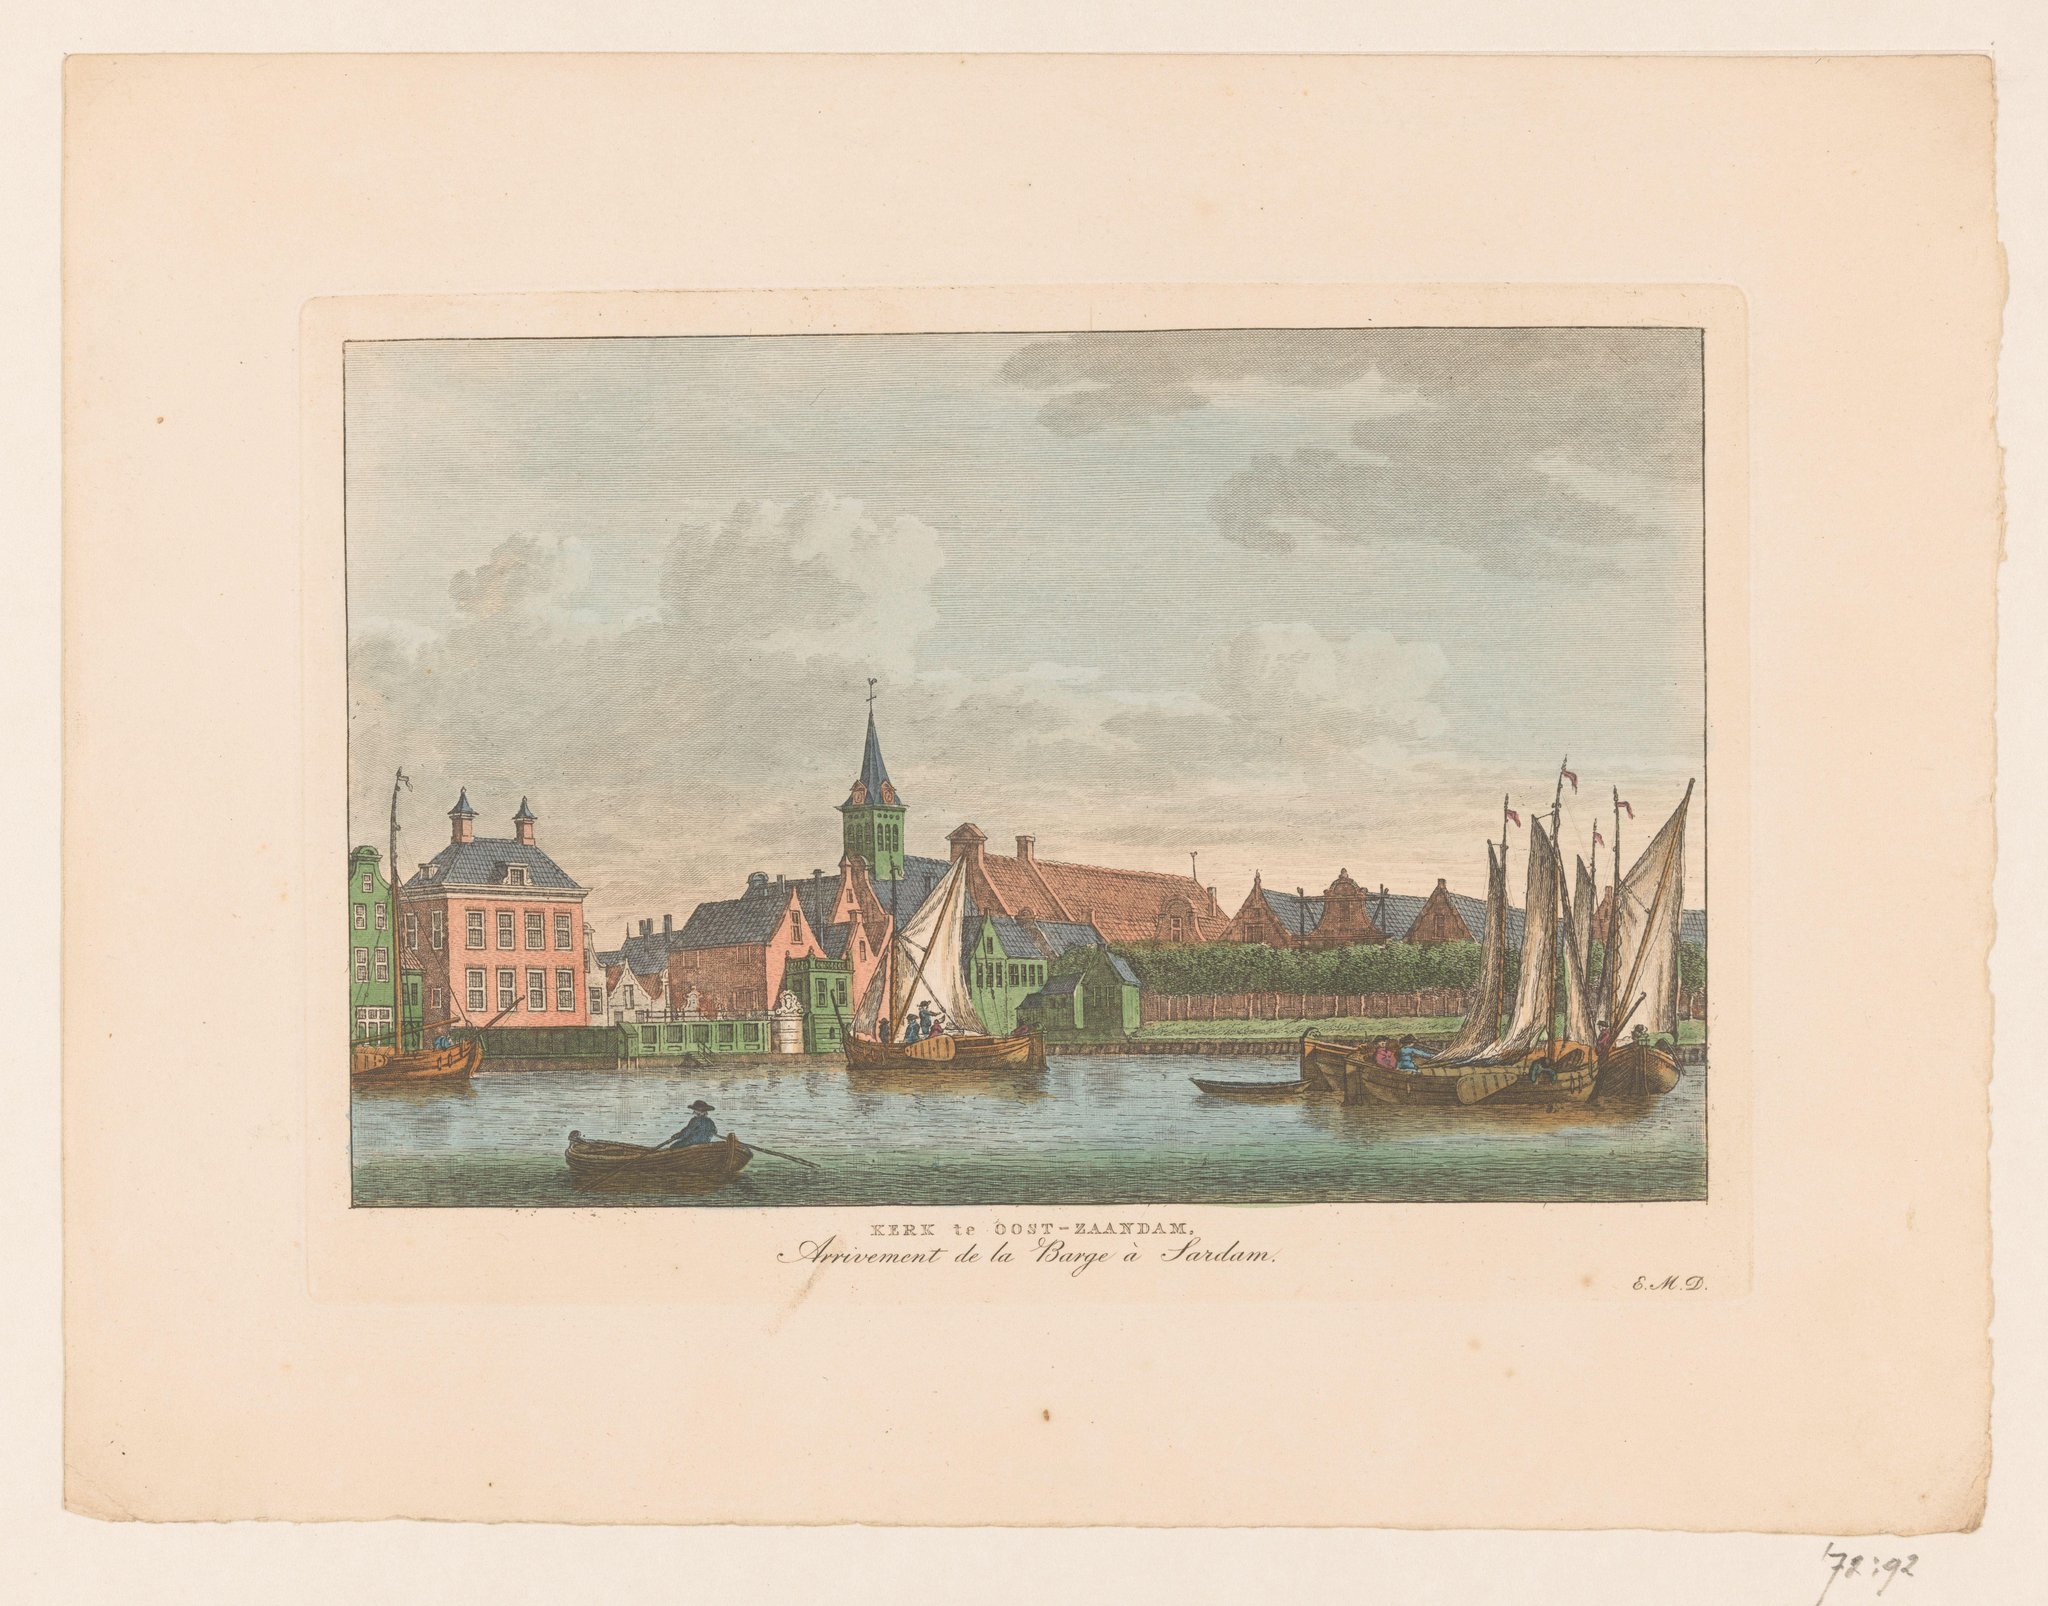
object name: print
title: Kerk te Oost-Zaandam / Arrivement de la Barge à Sardam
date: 1786-1792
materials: paper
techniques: etching, hand coloring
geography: amsterdam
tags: city-view, and landscape with man-made constructions, ships (in general)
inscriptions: collector's mark: Lugt 2228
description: Huidige staat van prent uitgegeven als onderdeel van een plaatwerk uit ca. 1824-1825 met 74 (ongenummerde) platen van de belangrijkste topografische gezichten en verschillende zeden en gewoonten in het Verenigd Koninkrijk der Nederlanden, getiteld 'Tableau des principales vues des palais et édifices : représentations et des coutumes et usages, dans les provinces septentrionales du Royaume des Pays-Bas'. Eerdere staat gebruikt in: Vaderlandsche gezichten, of afbeeldingen van den tegenwoordigen staat der Vereenigde Nederlanden (…). Amsterdam: Hendrik Gartman, Willem Vermandel en Jan Willem Smit, 1786-1792. Uitgegeven in afleveringen met ieder een eigen bifolium en inhoudsopgave. Alle prenten in deze publicatie zijn gegraveerd door Carel Frederik Bendorp (I) en, in de meeste gevallen, gebaseerd op tekeningen van Jan Bulthuis.